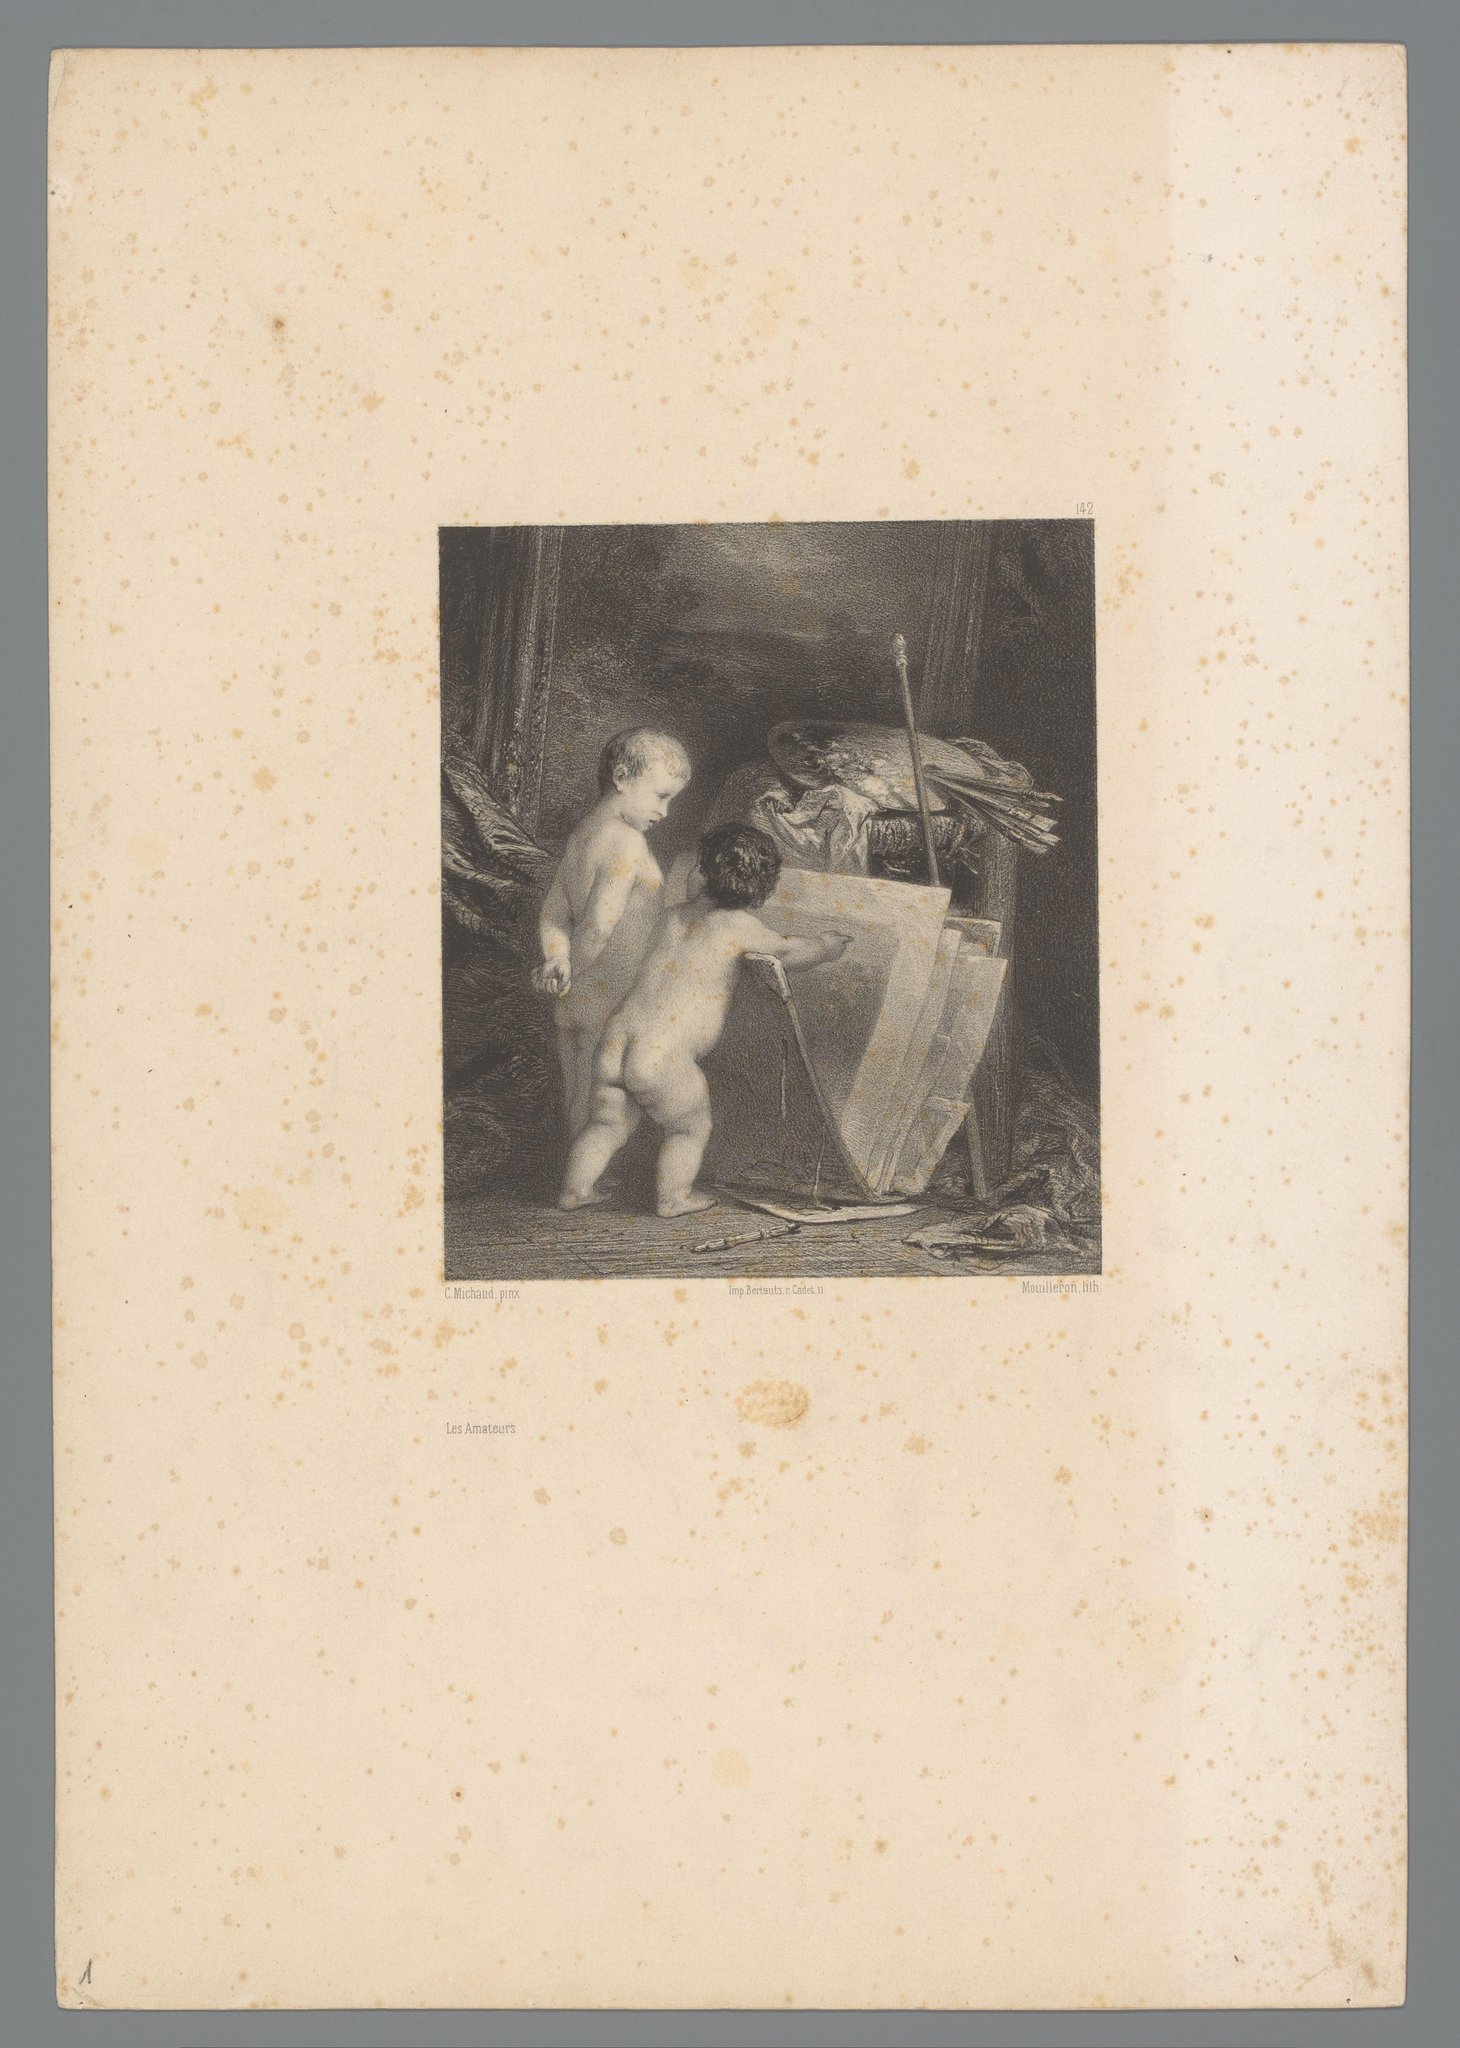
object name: print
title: Oude en hedendaagse kunstenaars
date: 1851-1862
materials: paper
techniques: lithograph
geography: paris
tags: child, art collecting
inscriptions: collector's mark: Lugt 2233, check stamp: Lugt 36a, inscription: ‘Aug Allebé’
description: De kleine kunstliefhebbers. Twee naakte kinderen bespreken een map met tekeningen. Links een palet met penselen, tegen de muur een groot schilderij.